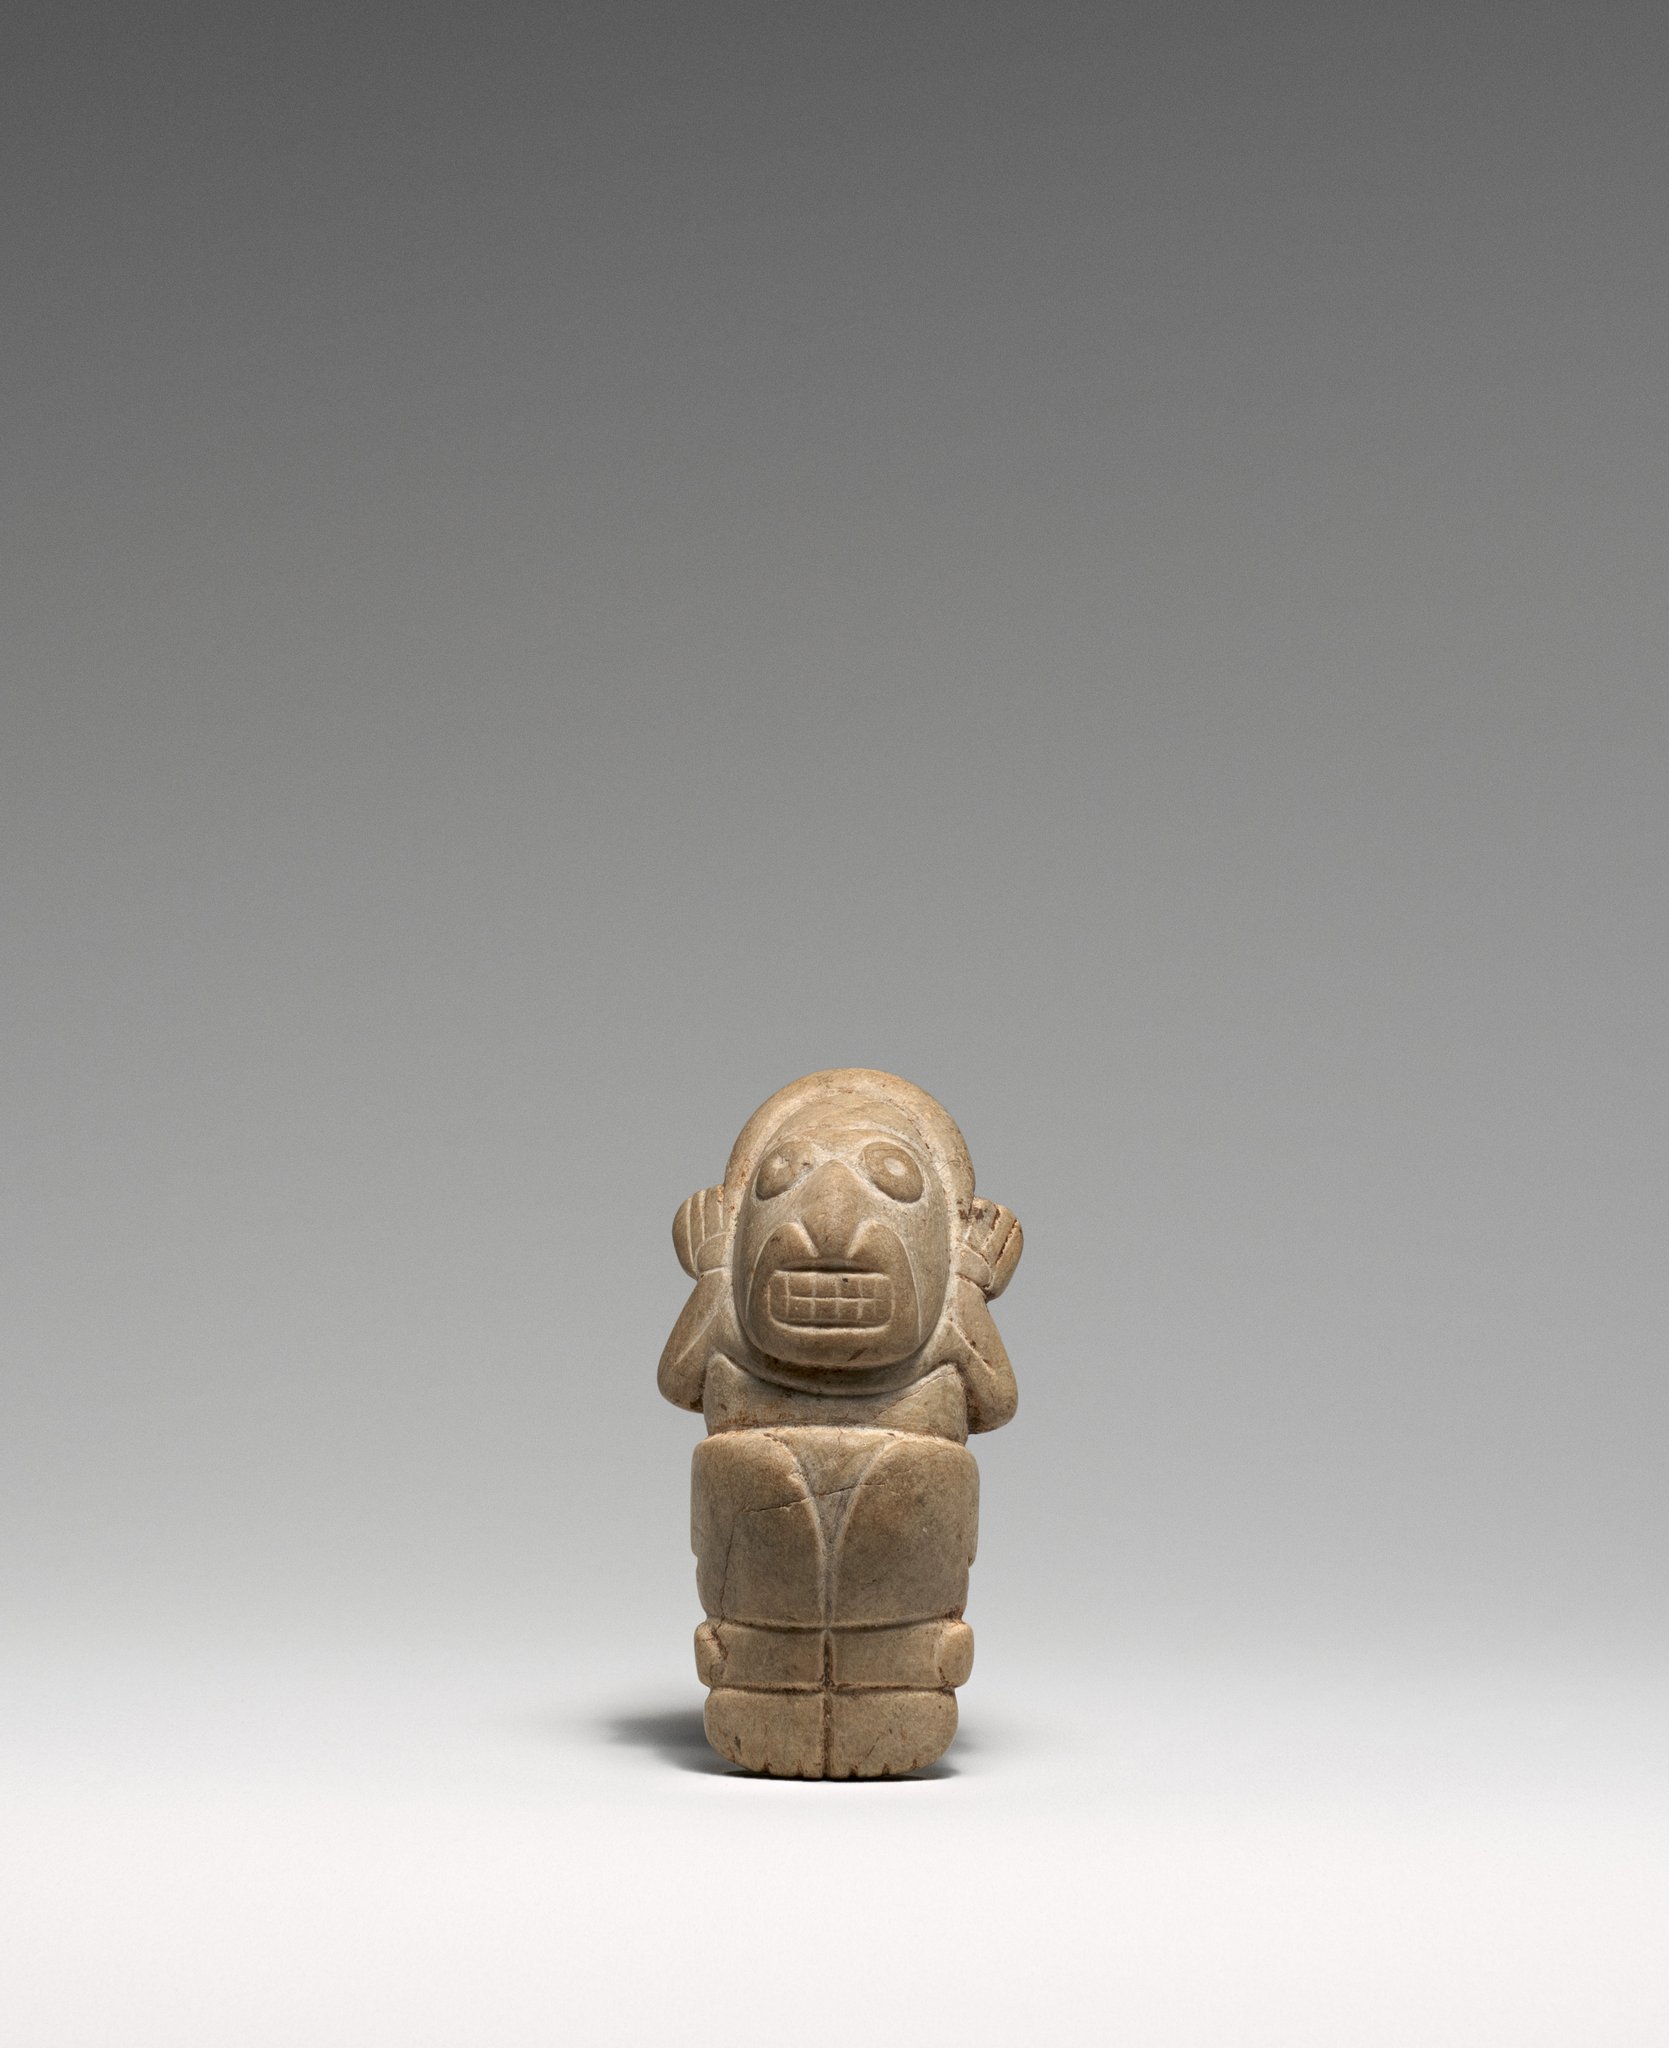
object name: ornament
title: Figure Pendant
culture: taíno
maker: taíno artist(s)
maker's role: artist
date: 1201-1500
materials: stone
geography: dominican republic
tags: human figures